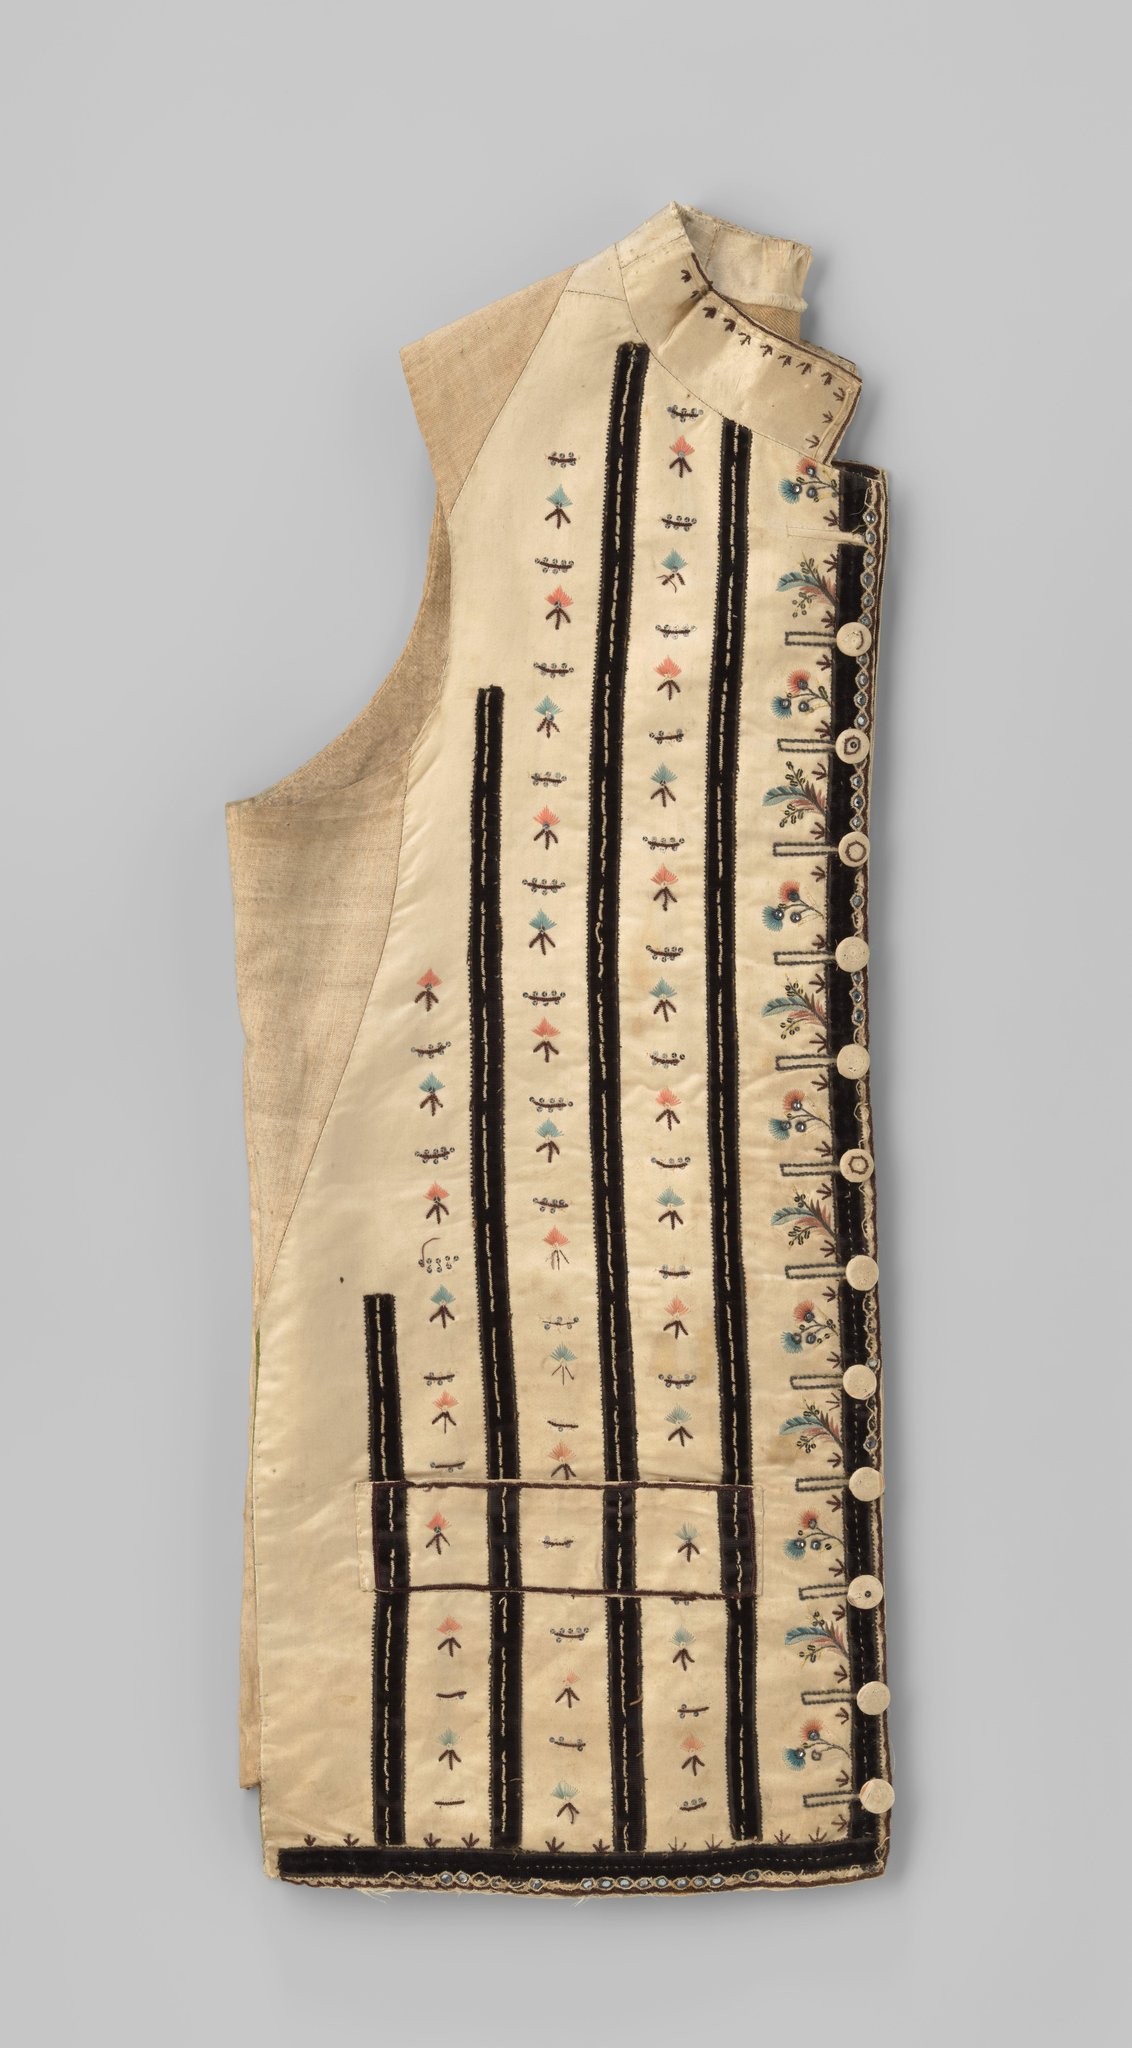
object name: menswear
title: Vest met staande kraag van wit satijn, versierd met zwarte fluwelen strepen met crème chenille en geborduurde strooi- en bloemmotieven met lovers en blauwe stenen; 12 knopen.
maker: Anonymous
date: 1790-1800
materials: glass, linen, textile, silk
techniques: embroidered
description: Vest van wit satijn. Opgelegde zwart fluwelen strepen en gekleurde zijden bloemen met pailletten, lovertjes en chenille. Versierde staande kraag.